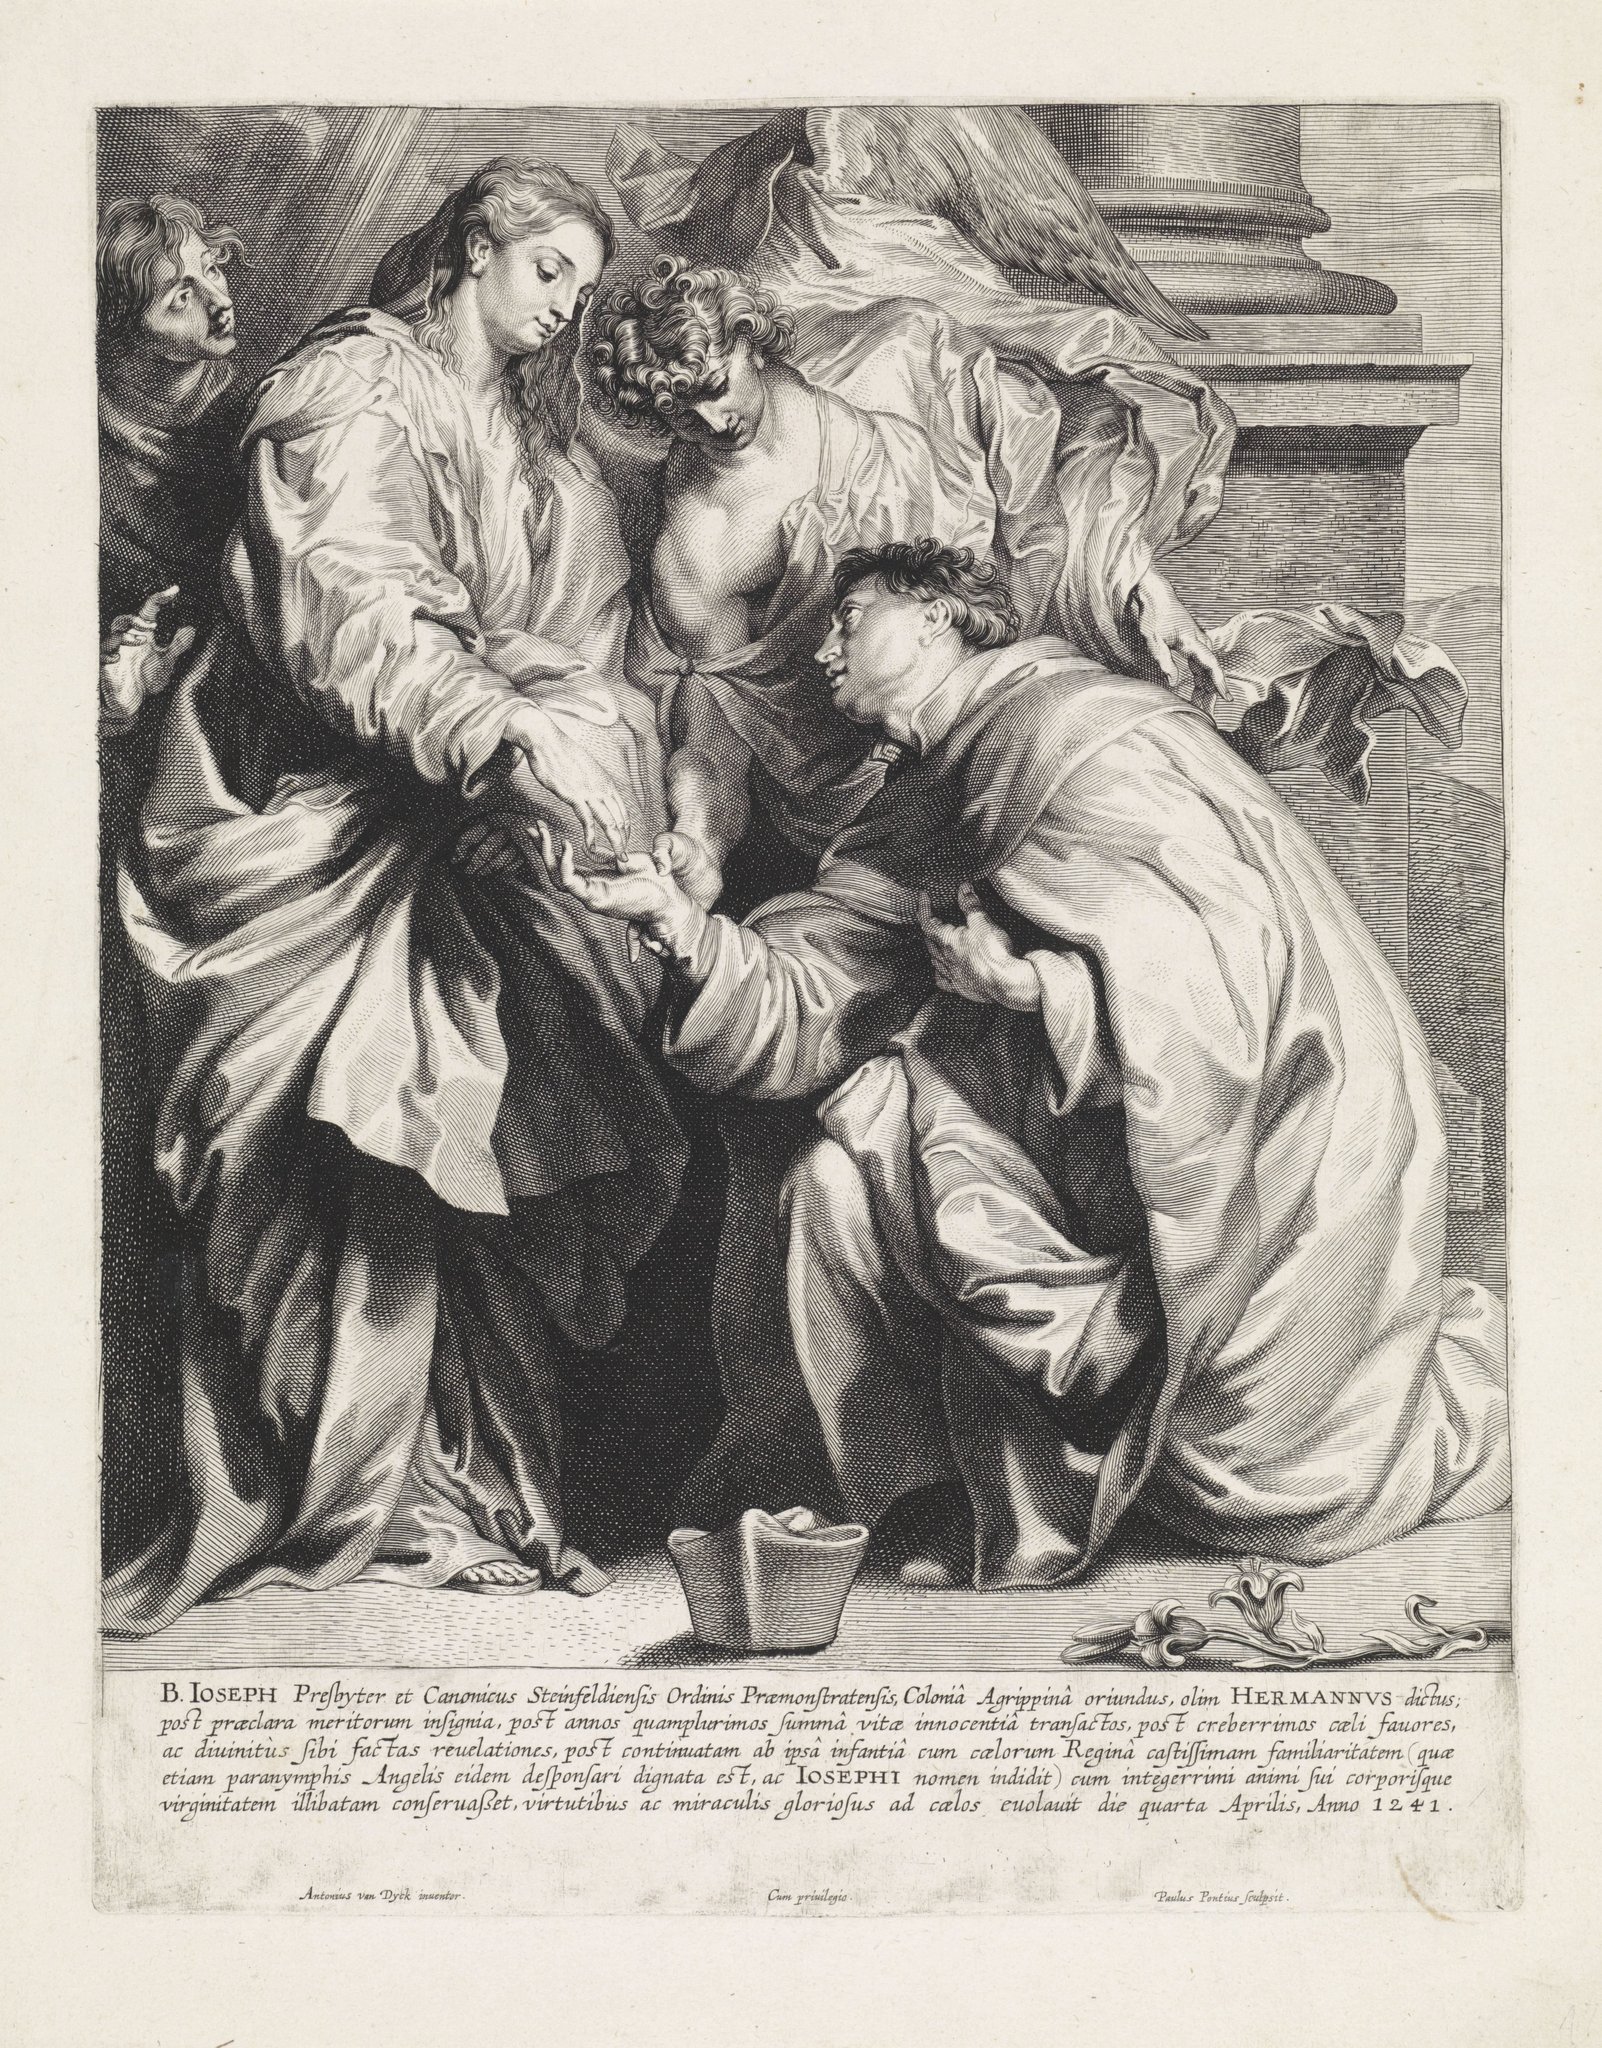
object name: print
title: Visioen van H. Hermann Joseph (versie a)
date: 1616-1657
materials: paper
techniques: engraving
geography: antwerp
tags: the praemonstratense friar herman joseph of steinfeld; possible attributes of st. herman joseph: book, branch of roses, cup (with roses), infant christ, key, knife, head-gear, appearances of mary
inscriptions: collector's mark: Lugt 240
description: De maagd Maria verschijnt aan de Heilige Hermann Joseph van Steinfeld. Ze wordt geflankeerd door twee engelen. Op de voorgrond de biretta van de heilige en zijn attribuut de roos. In de marge een vijfregelig onderschrift in het Latijn.